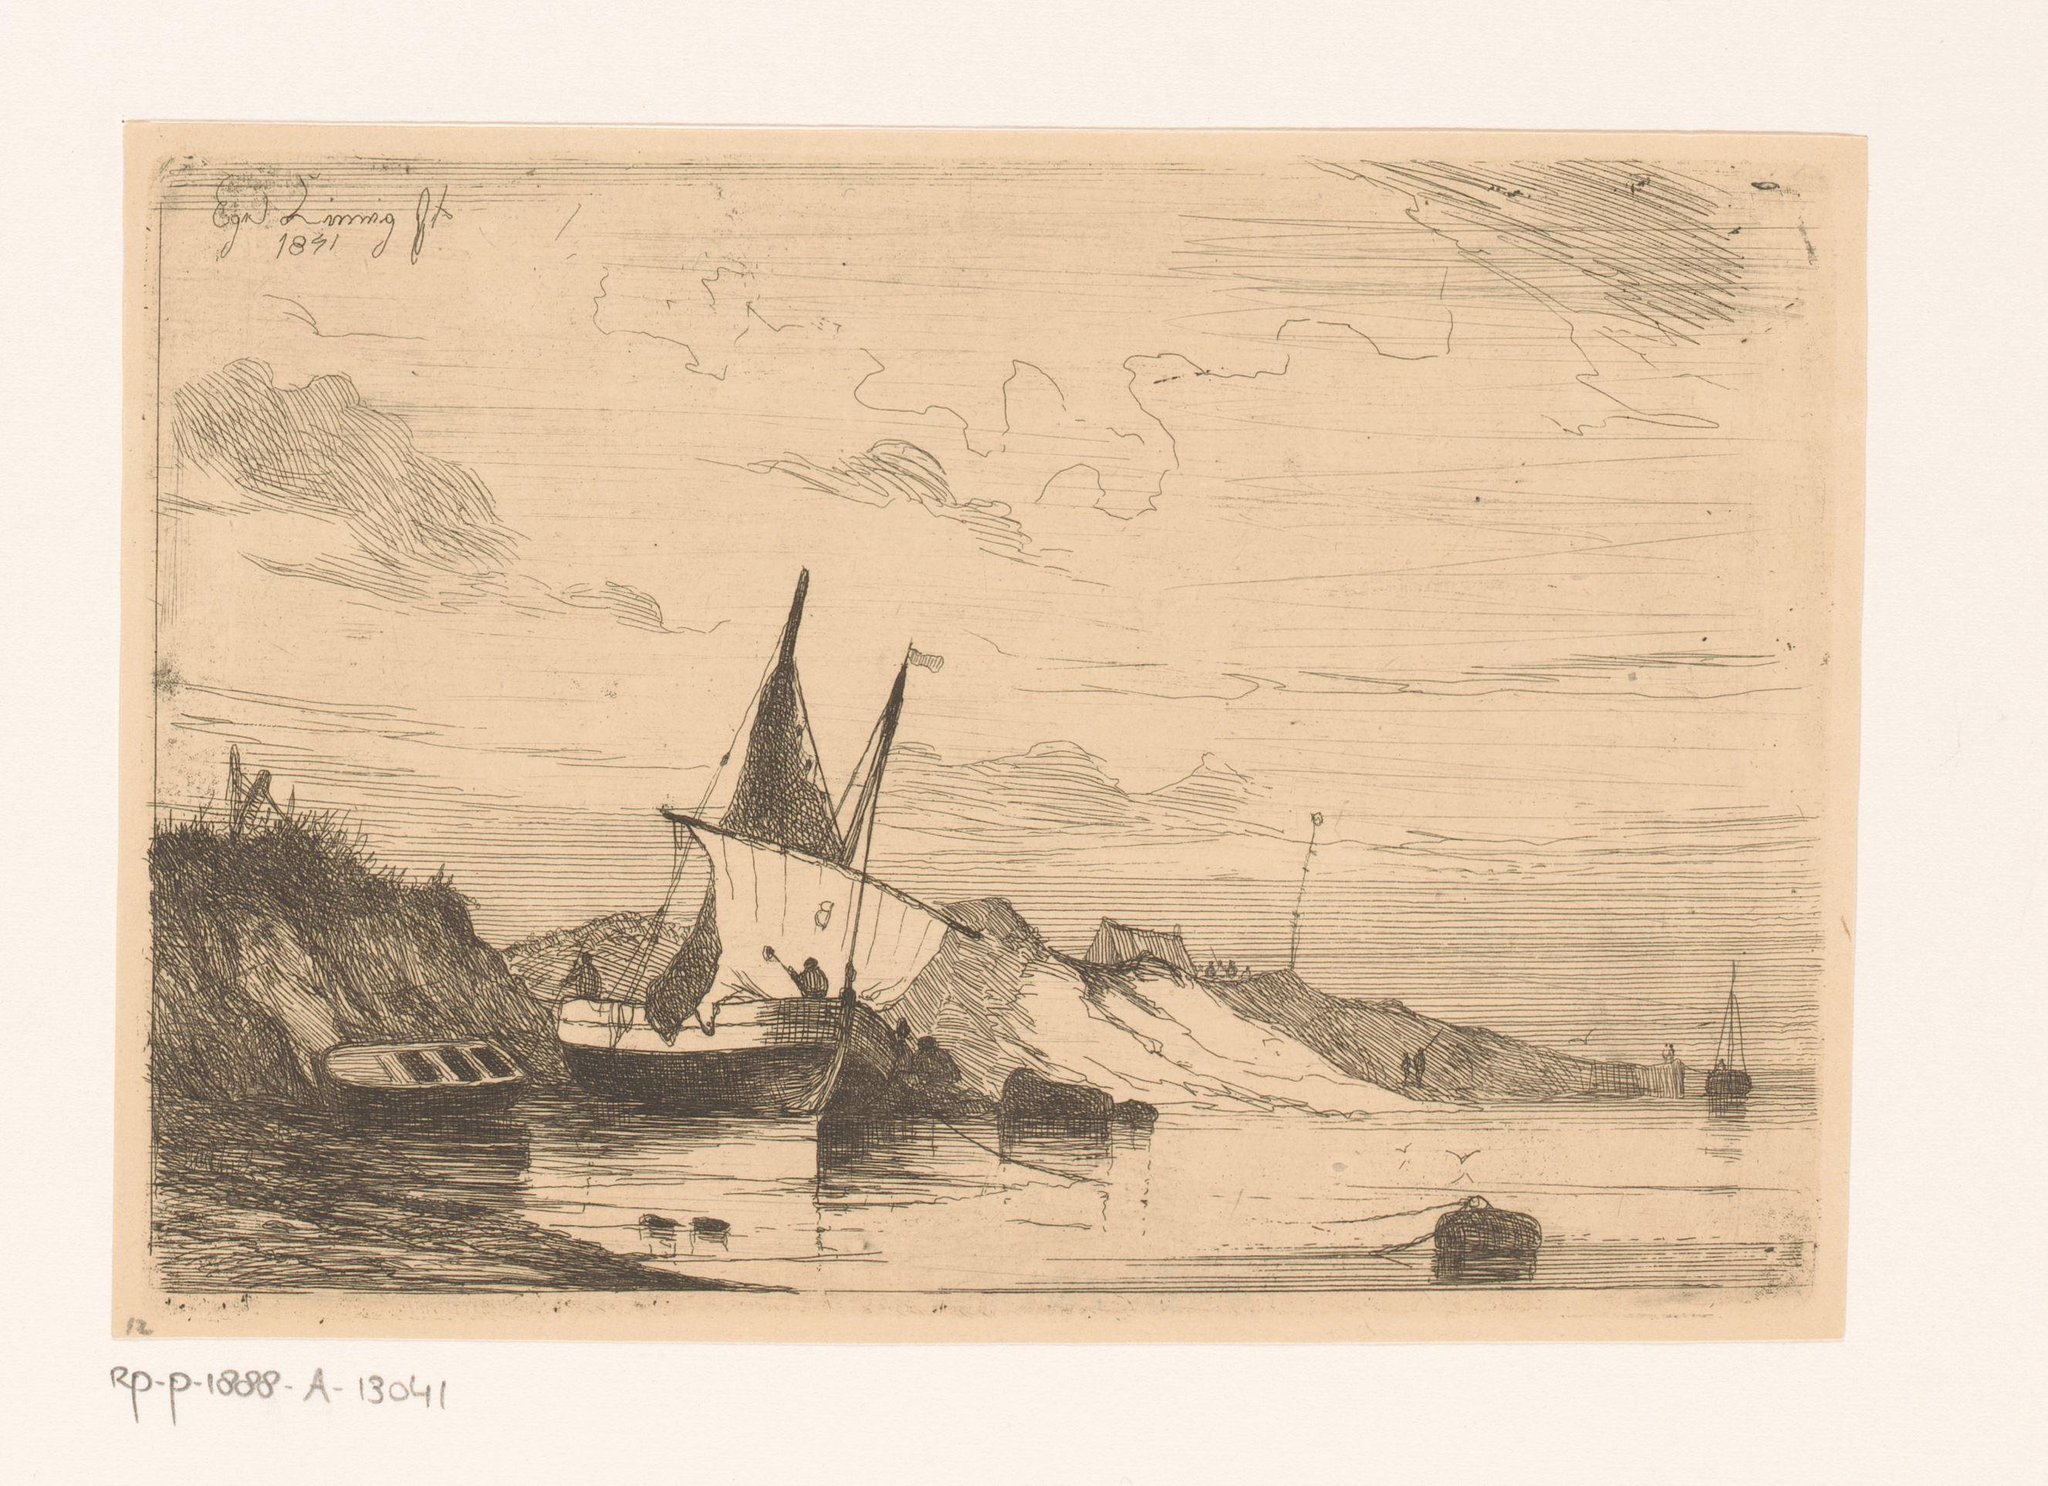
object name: print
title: Vissersboot bij de duinen van Blankenberge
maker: egidius linnig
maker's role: draughtsman, print maker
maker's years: 1821-1860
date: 1841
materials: paper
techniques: etching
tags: dune coast, sailing-ship, sailing-boat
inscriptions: collector's mark: Lugt 2228